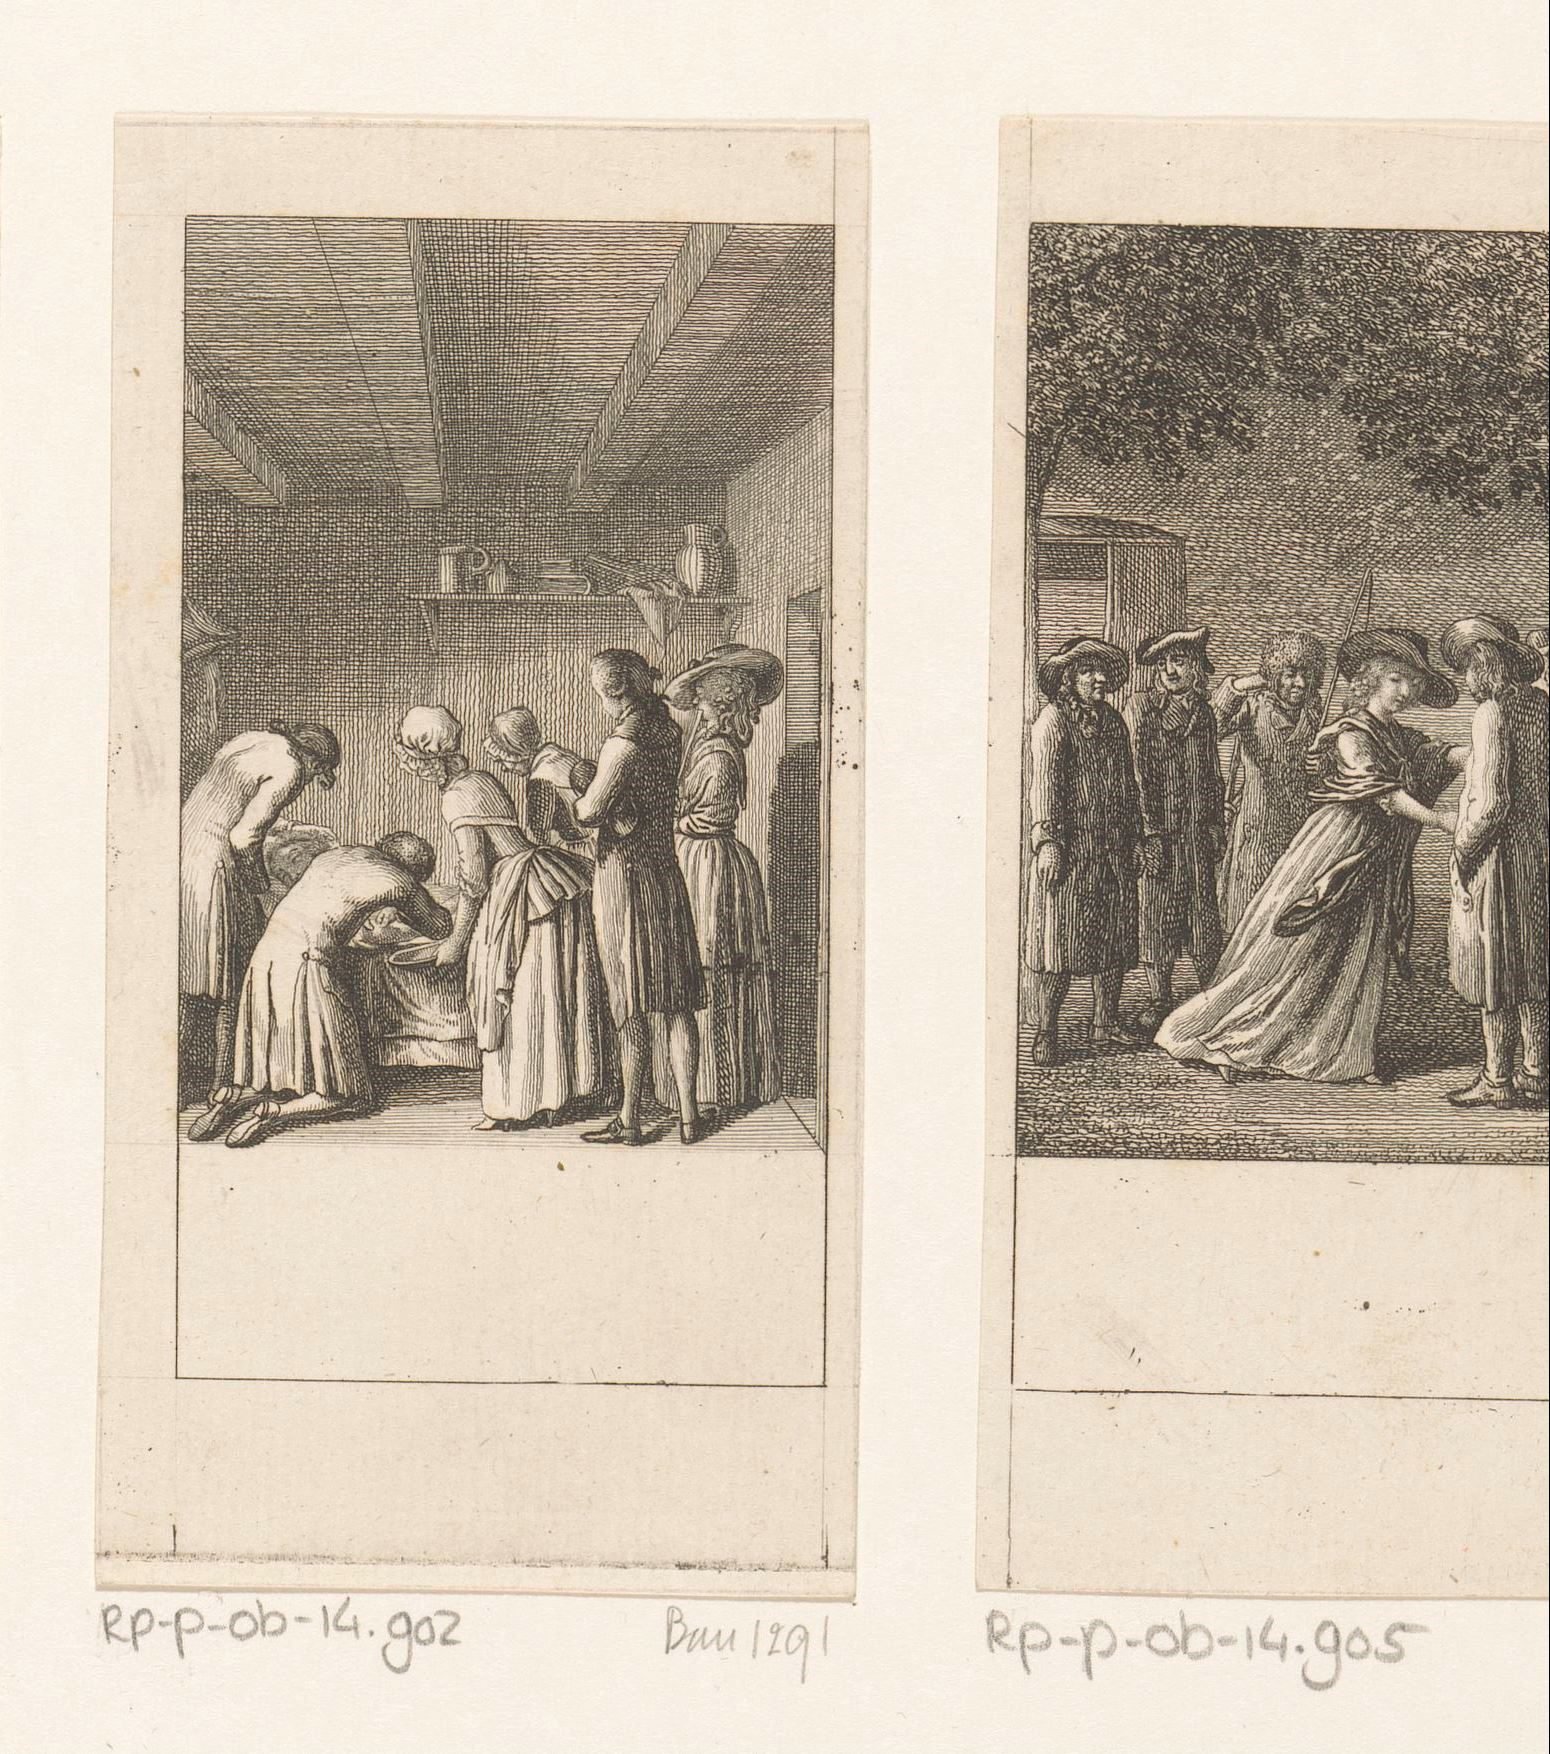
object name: print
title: Sir Robert en zijn zus kijken toe hoe Camille een waskom vasthoudt en de arts de zieken verzorgt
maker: daniel nikolaus chodowiecki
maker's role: draughtsman, print maker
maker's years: 1726-1801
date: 1787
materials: paper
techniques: etching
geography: berlin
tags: vienna, waiting, watching, literature, interior of the house, nursing, tending the sick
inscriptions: collector's mark: Lugt 2228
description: Vervaardigd voor J. F. Jünger's vertaling van 'Camille: oder, Briefe zweyer Mädchen aus unserm Zeitalter'. Een latere staat gebruikt in: Genealogischer Taschenkalender. Auf das Jahr 1788. Berlijn: Königl. Academie der Wissenschaften, 1787.